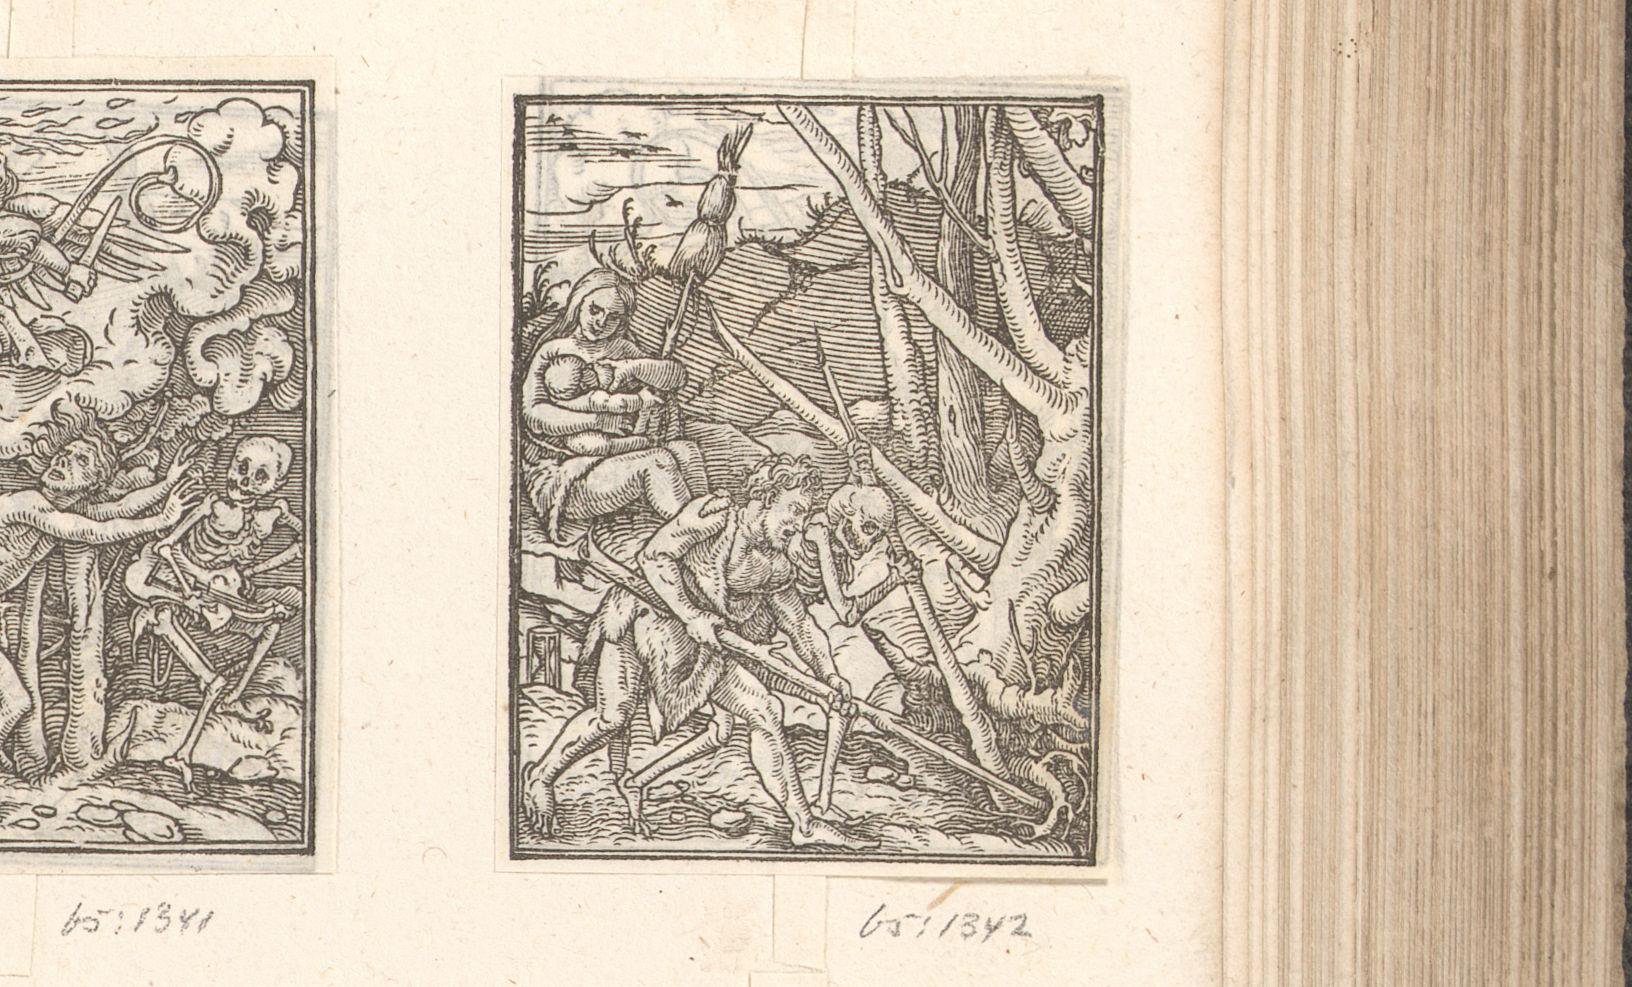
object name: album leaf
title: Adam en Eva aan het werk na de zondeval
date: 1524-1526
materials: paper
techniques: woodcut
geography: switzerland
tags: death as skeleton, adam engaged in agricultural activities, eve suckling the children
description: Adam werkt op het land met een ploeg in zijn hand, naast hem staat de Dood in de gedaante van een skelet. Eva geeft haar kind de borst en zij houdt een spinrok vast. Prent maakt deel uit van een album.